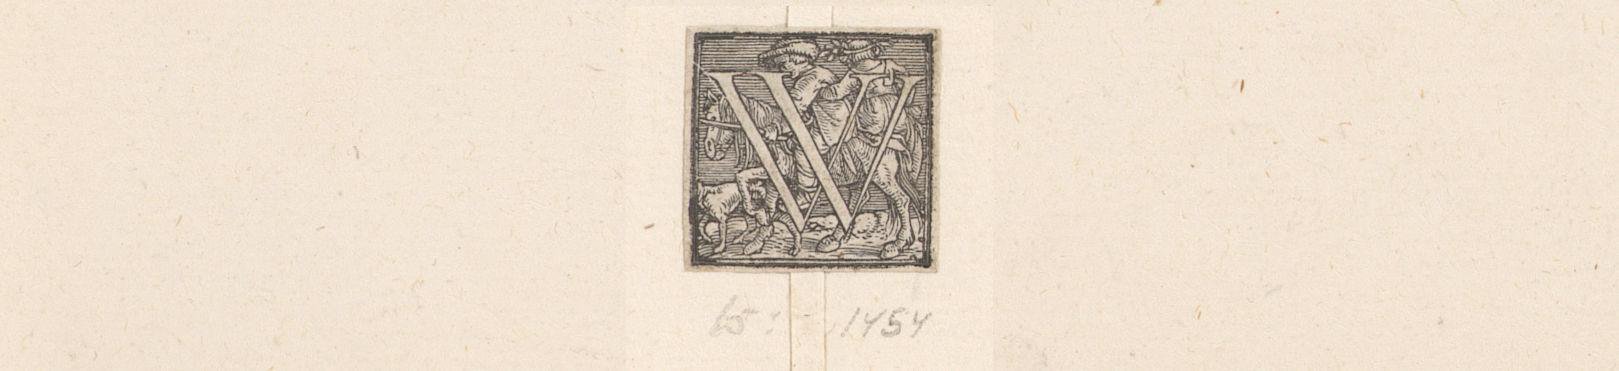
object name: album leaf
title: Latijns alfabet met boeren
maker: hans lützelburger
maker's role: print maker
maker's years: -1526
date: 1525-1526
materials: paper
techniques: woodcut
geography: basel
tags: riding a horse, ass, or mule; rider, horseman (+ two persons ~ traffic and transport), initial, farmers